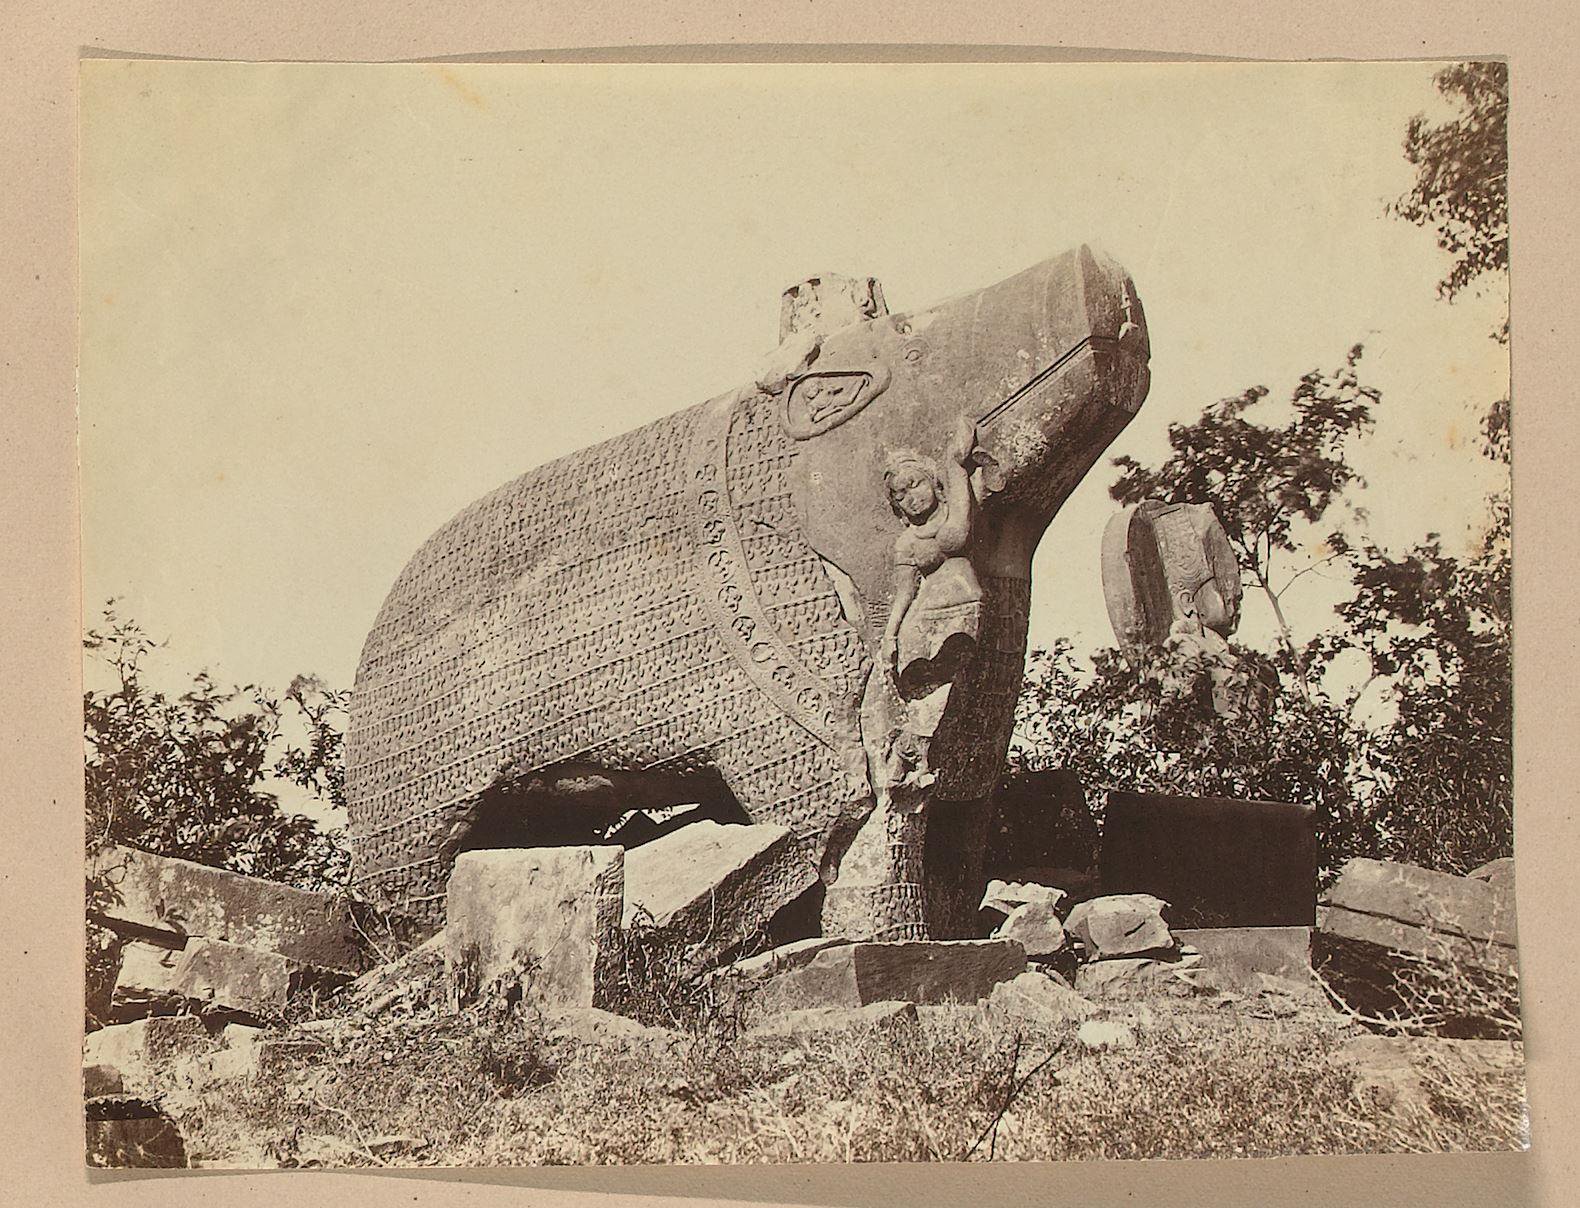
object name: photograph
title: India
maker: james john waterhouse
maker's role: fotograaf, luitenant, officier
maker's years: 1842-1928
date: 1860-1865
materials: cardboard, paper, photographic support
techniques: albumen print